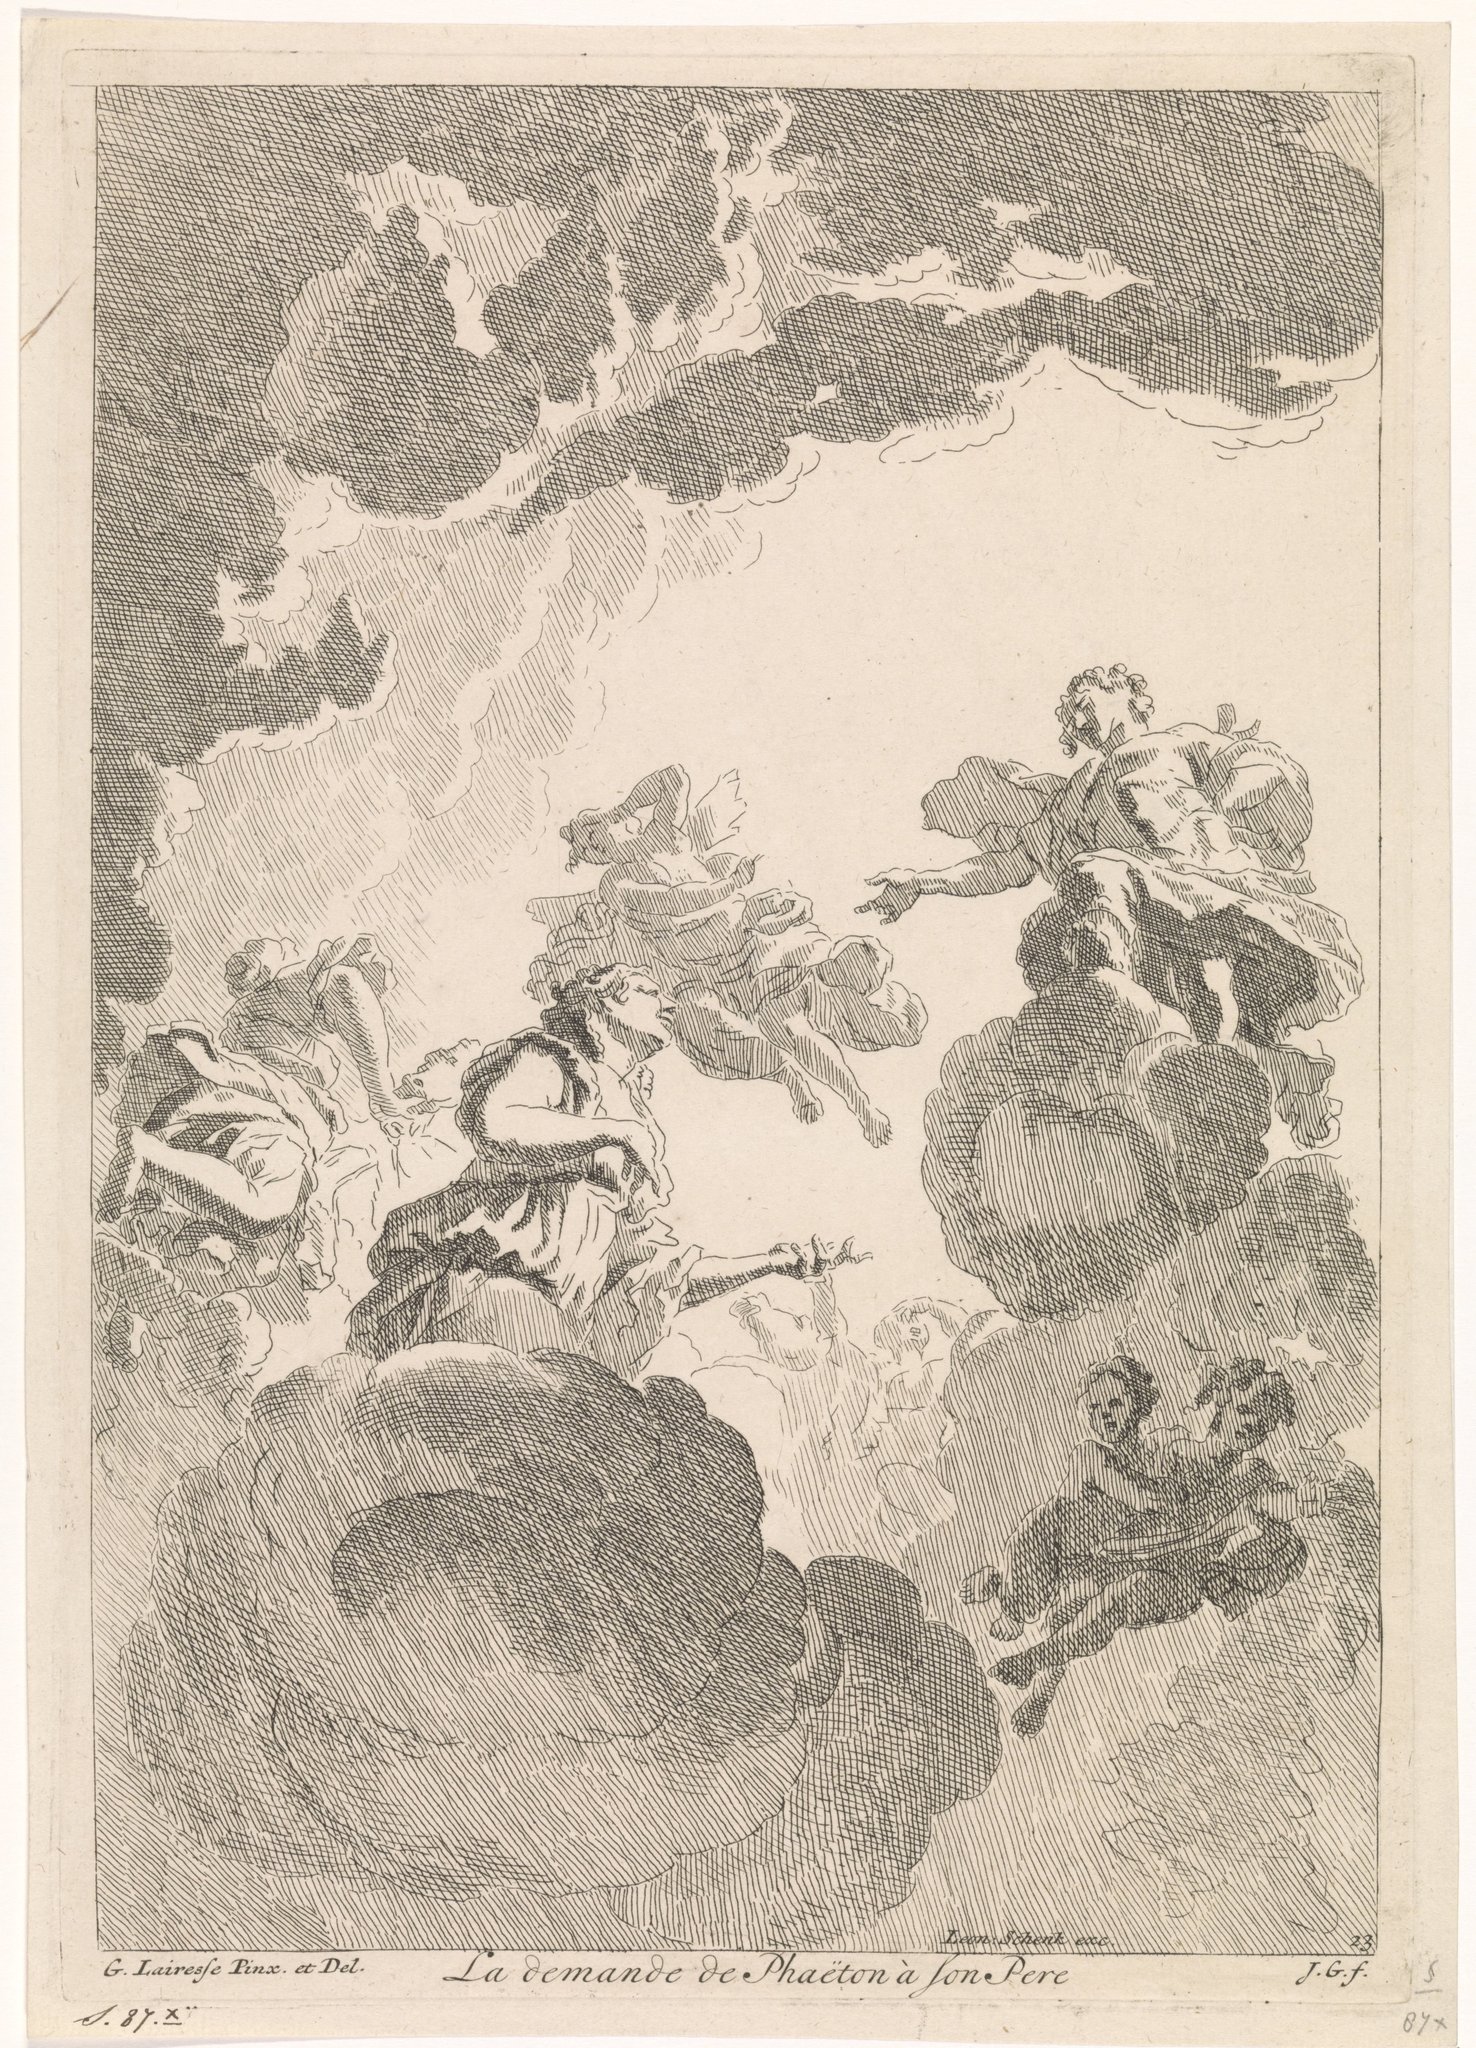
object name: print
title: La demande de Phaëton à son Pere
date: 1670-1726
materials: paper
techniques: etching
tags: phaethon asks apollo (sol) for the chariot of the sun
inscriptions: number: ‘S.87x’, collector's mark: Lugt 11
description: In de wolken vraagt Phaëthon toestemming aan zijn vader om met de zonnewagen te rijden. De prent is naar een verloren plafondschilderij van Gerard de Lairesse en maakt deel uit van een serie met Bijbelse, mythologische en allegorische voorstellingen.